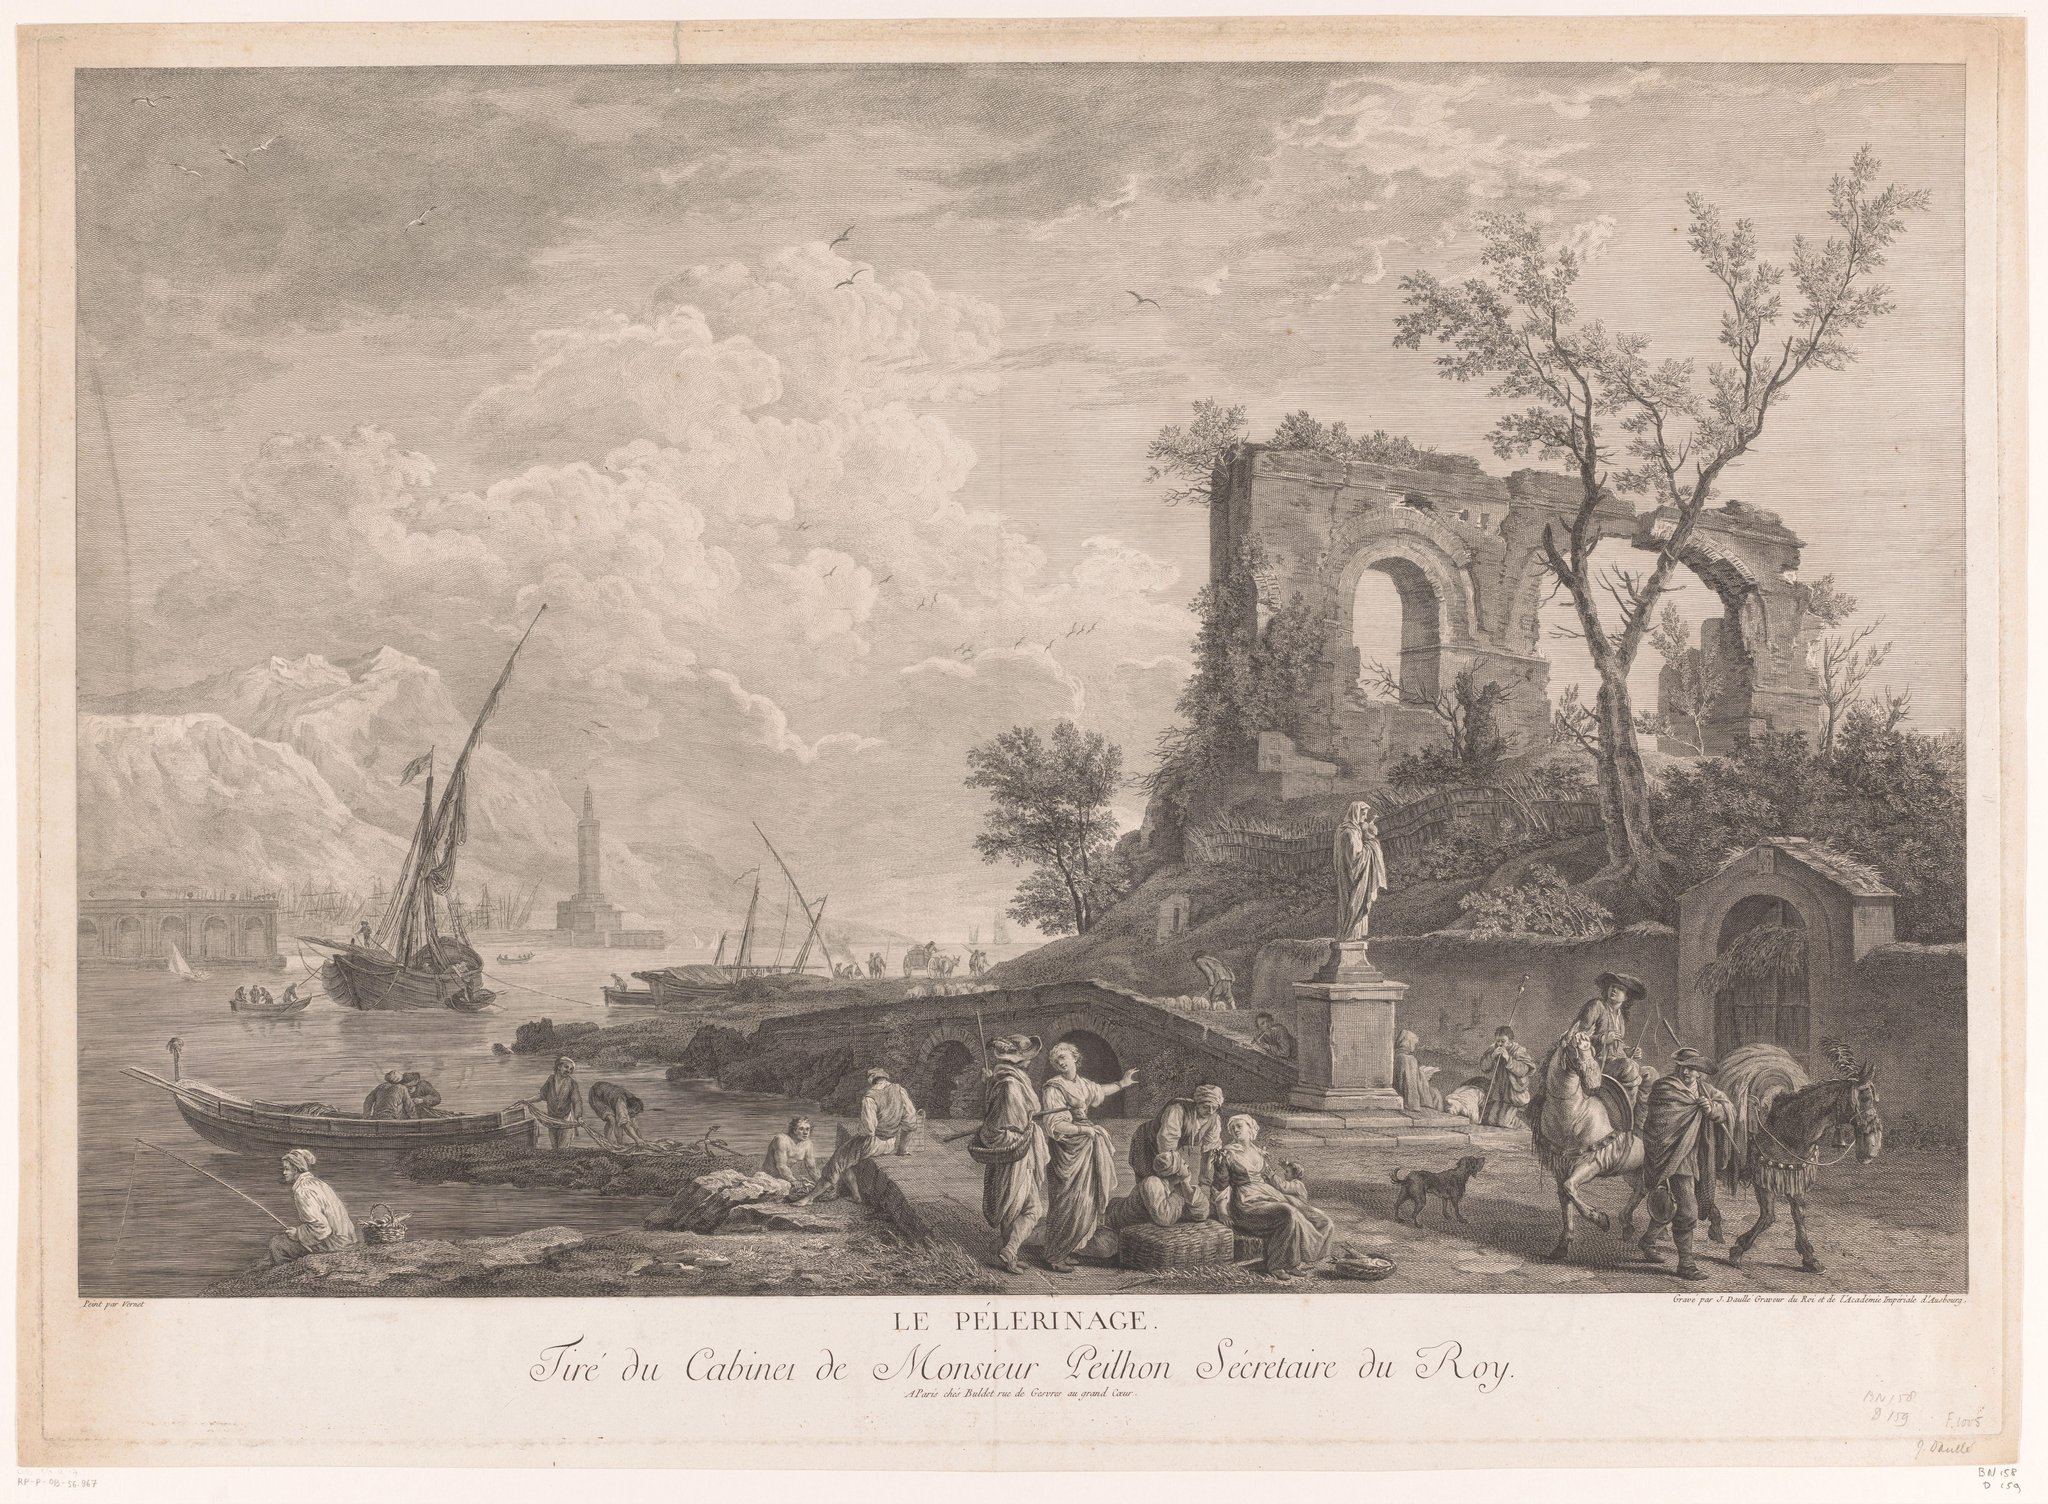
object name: print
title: Le pélerinage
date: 1760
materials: paper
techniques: engraving, etching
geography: paris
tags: harbour, pilgrim(s), landscape with ruins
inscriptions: watermark